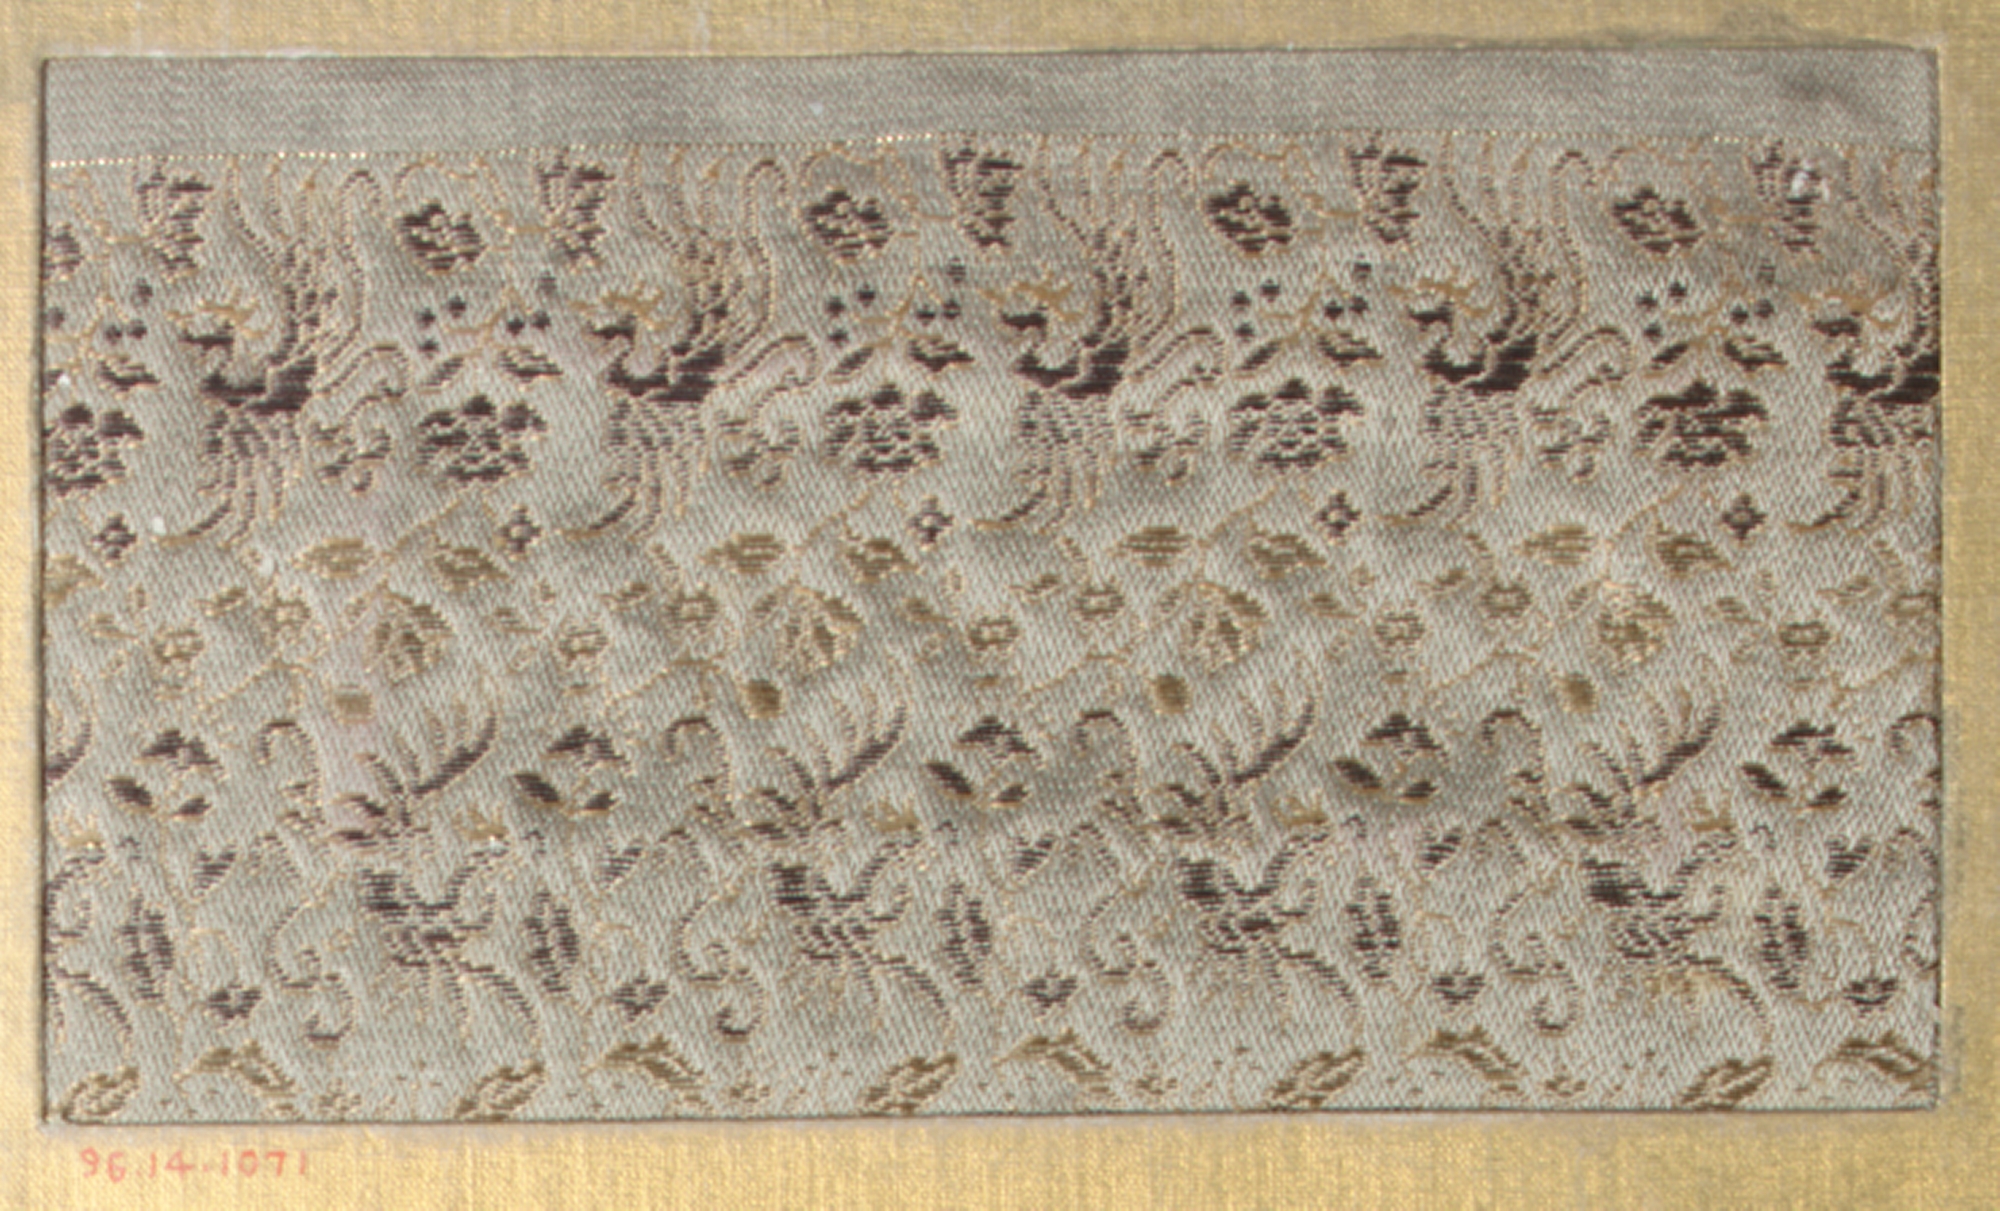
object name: piece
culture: japanese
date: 1701-1900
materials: silk